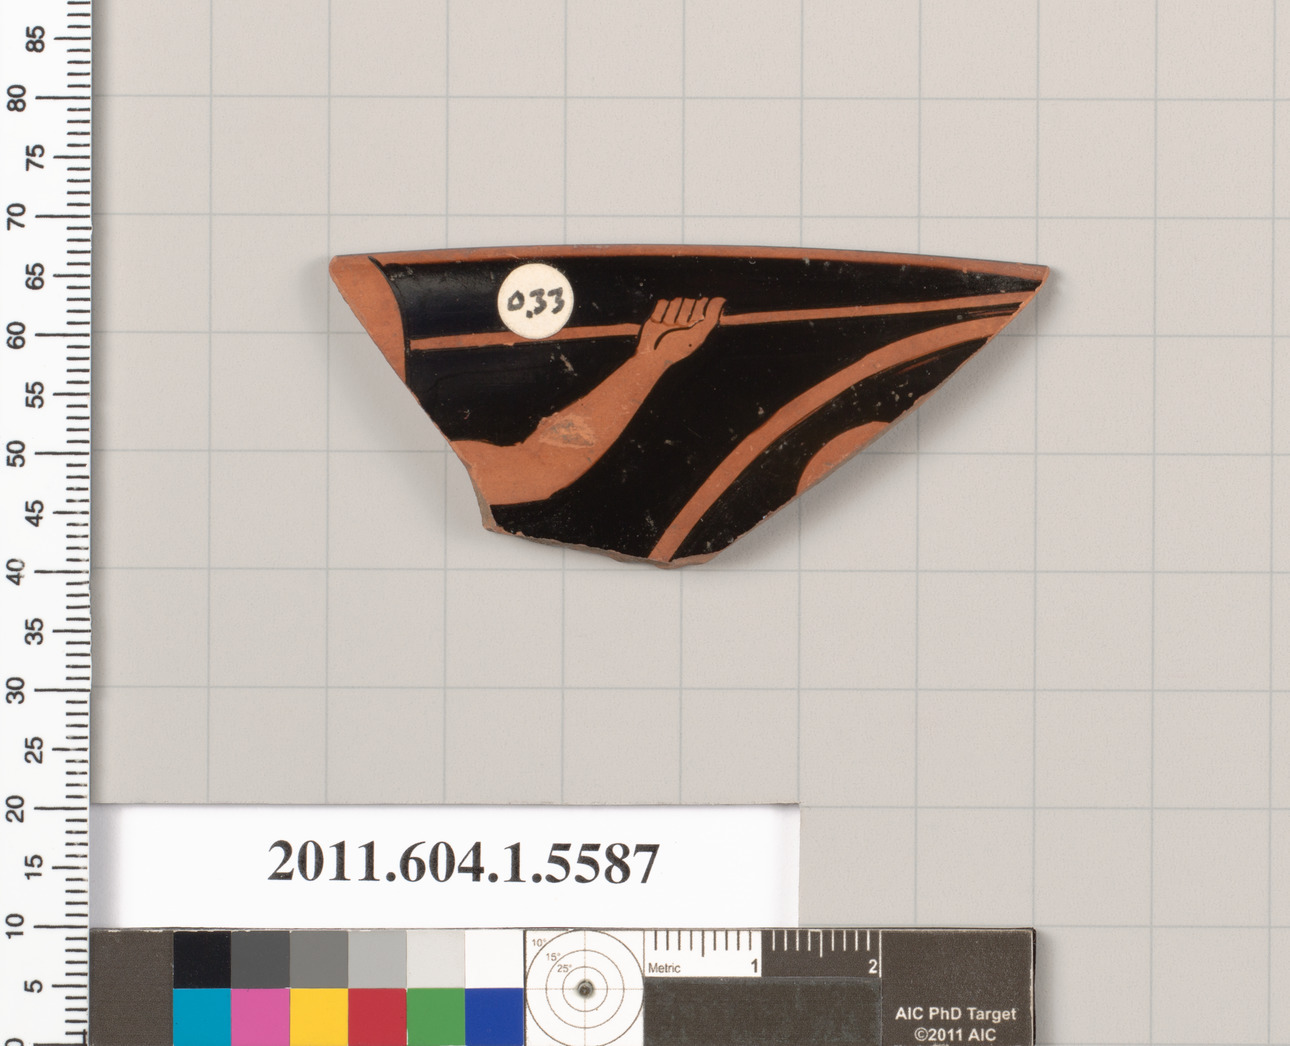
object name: kylix fragment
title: Terracotta rim fragment of a kylix (drinking cup)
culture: greek, attic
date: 520-500 BCE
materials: terracotta